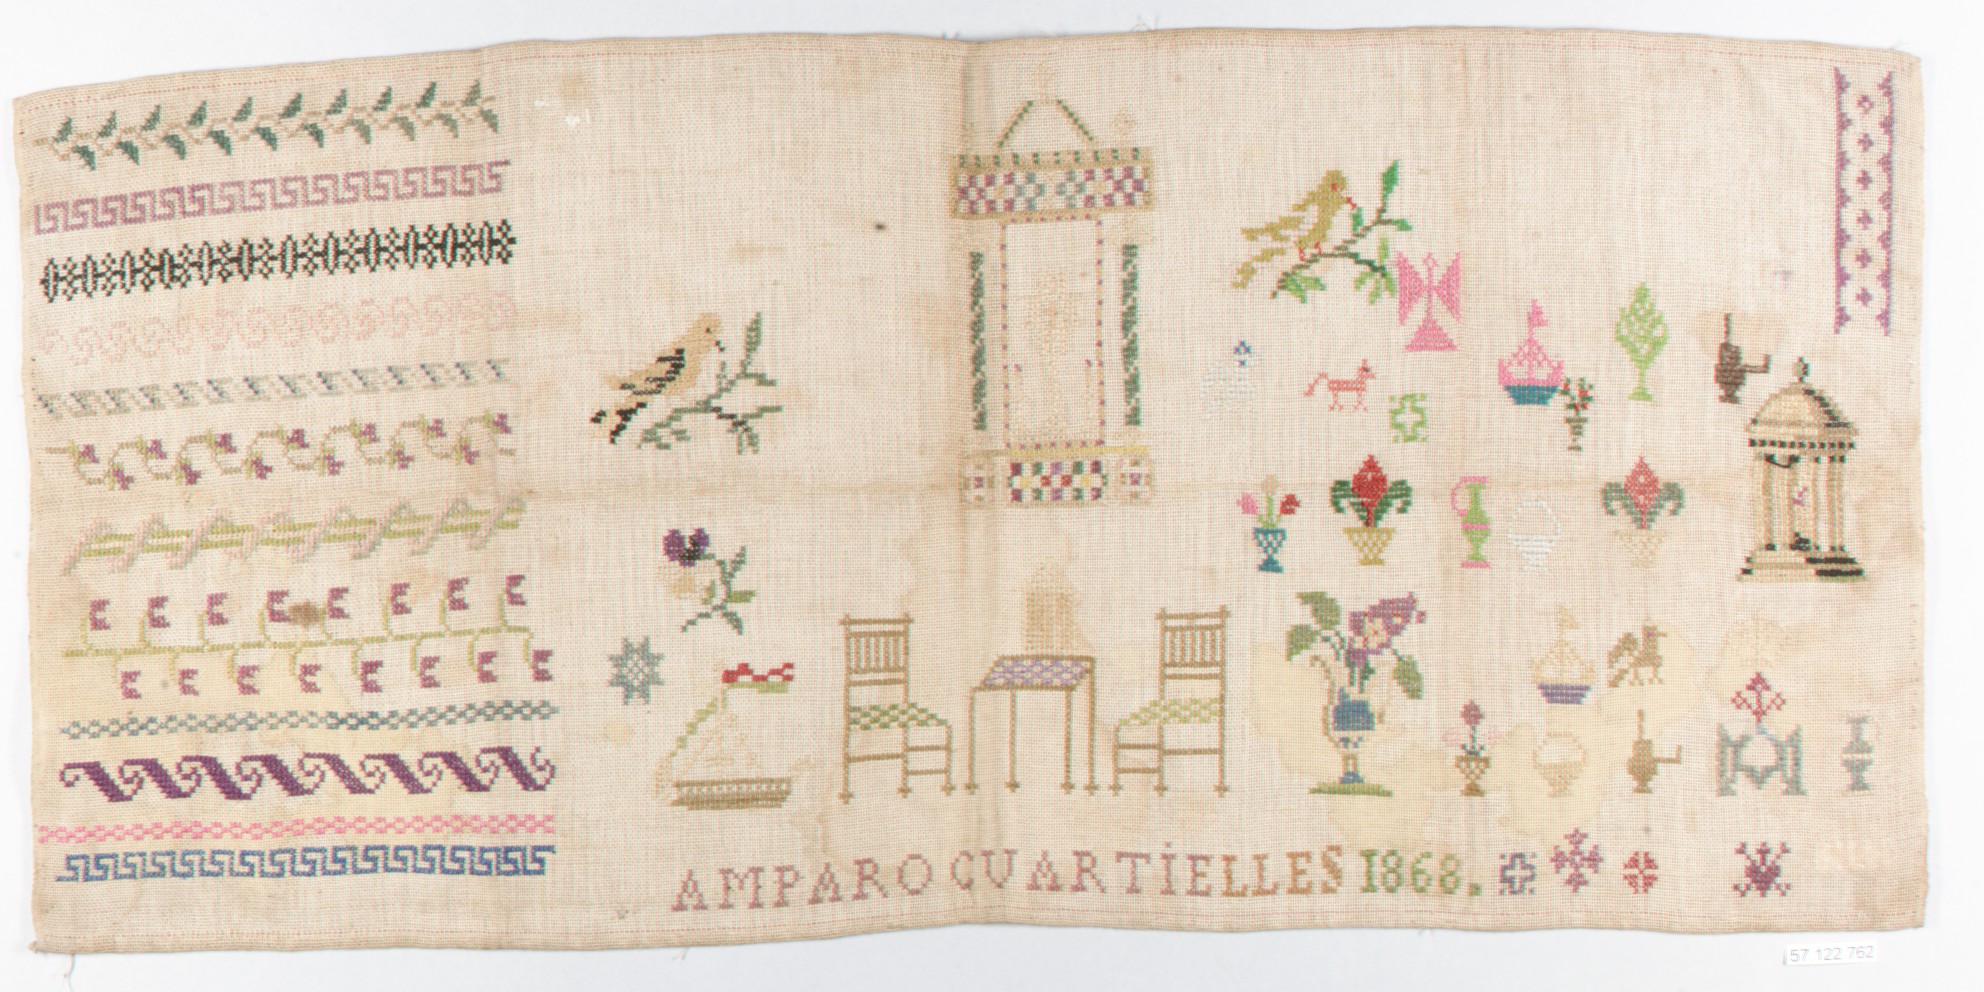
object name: sampler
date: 1868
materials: canvas, silk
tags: birds,flowers